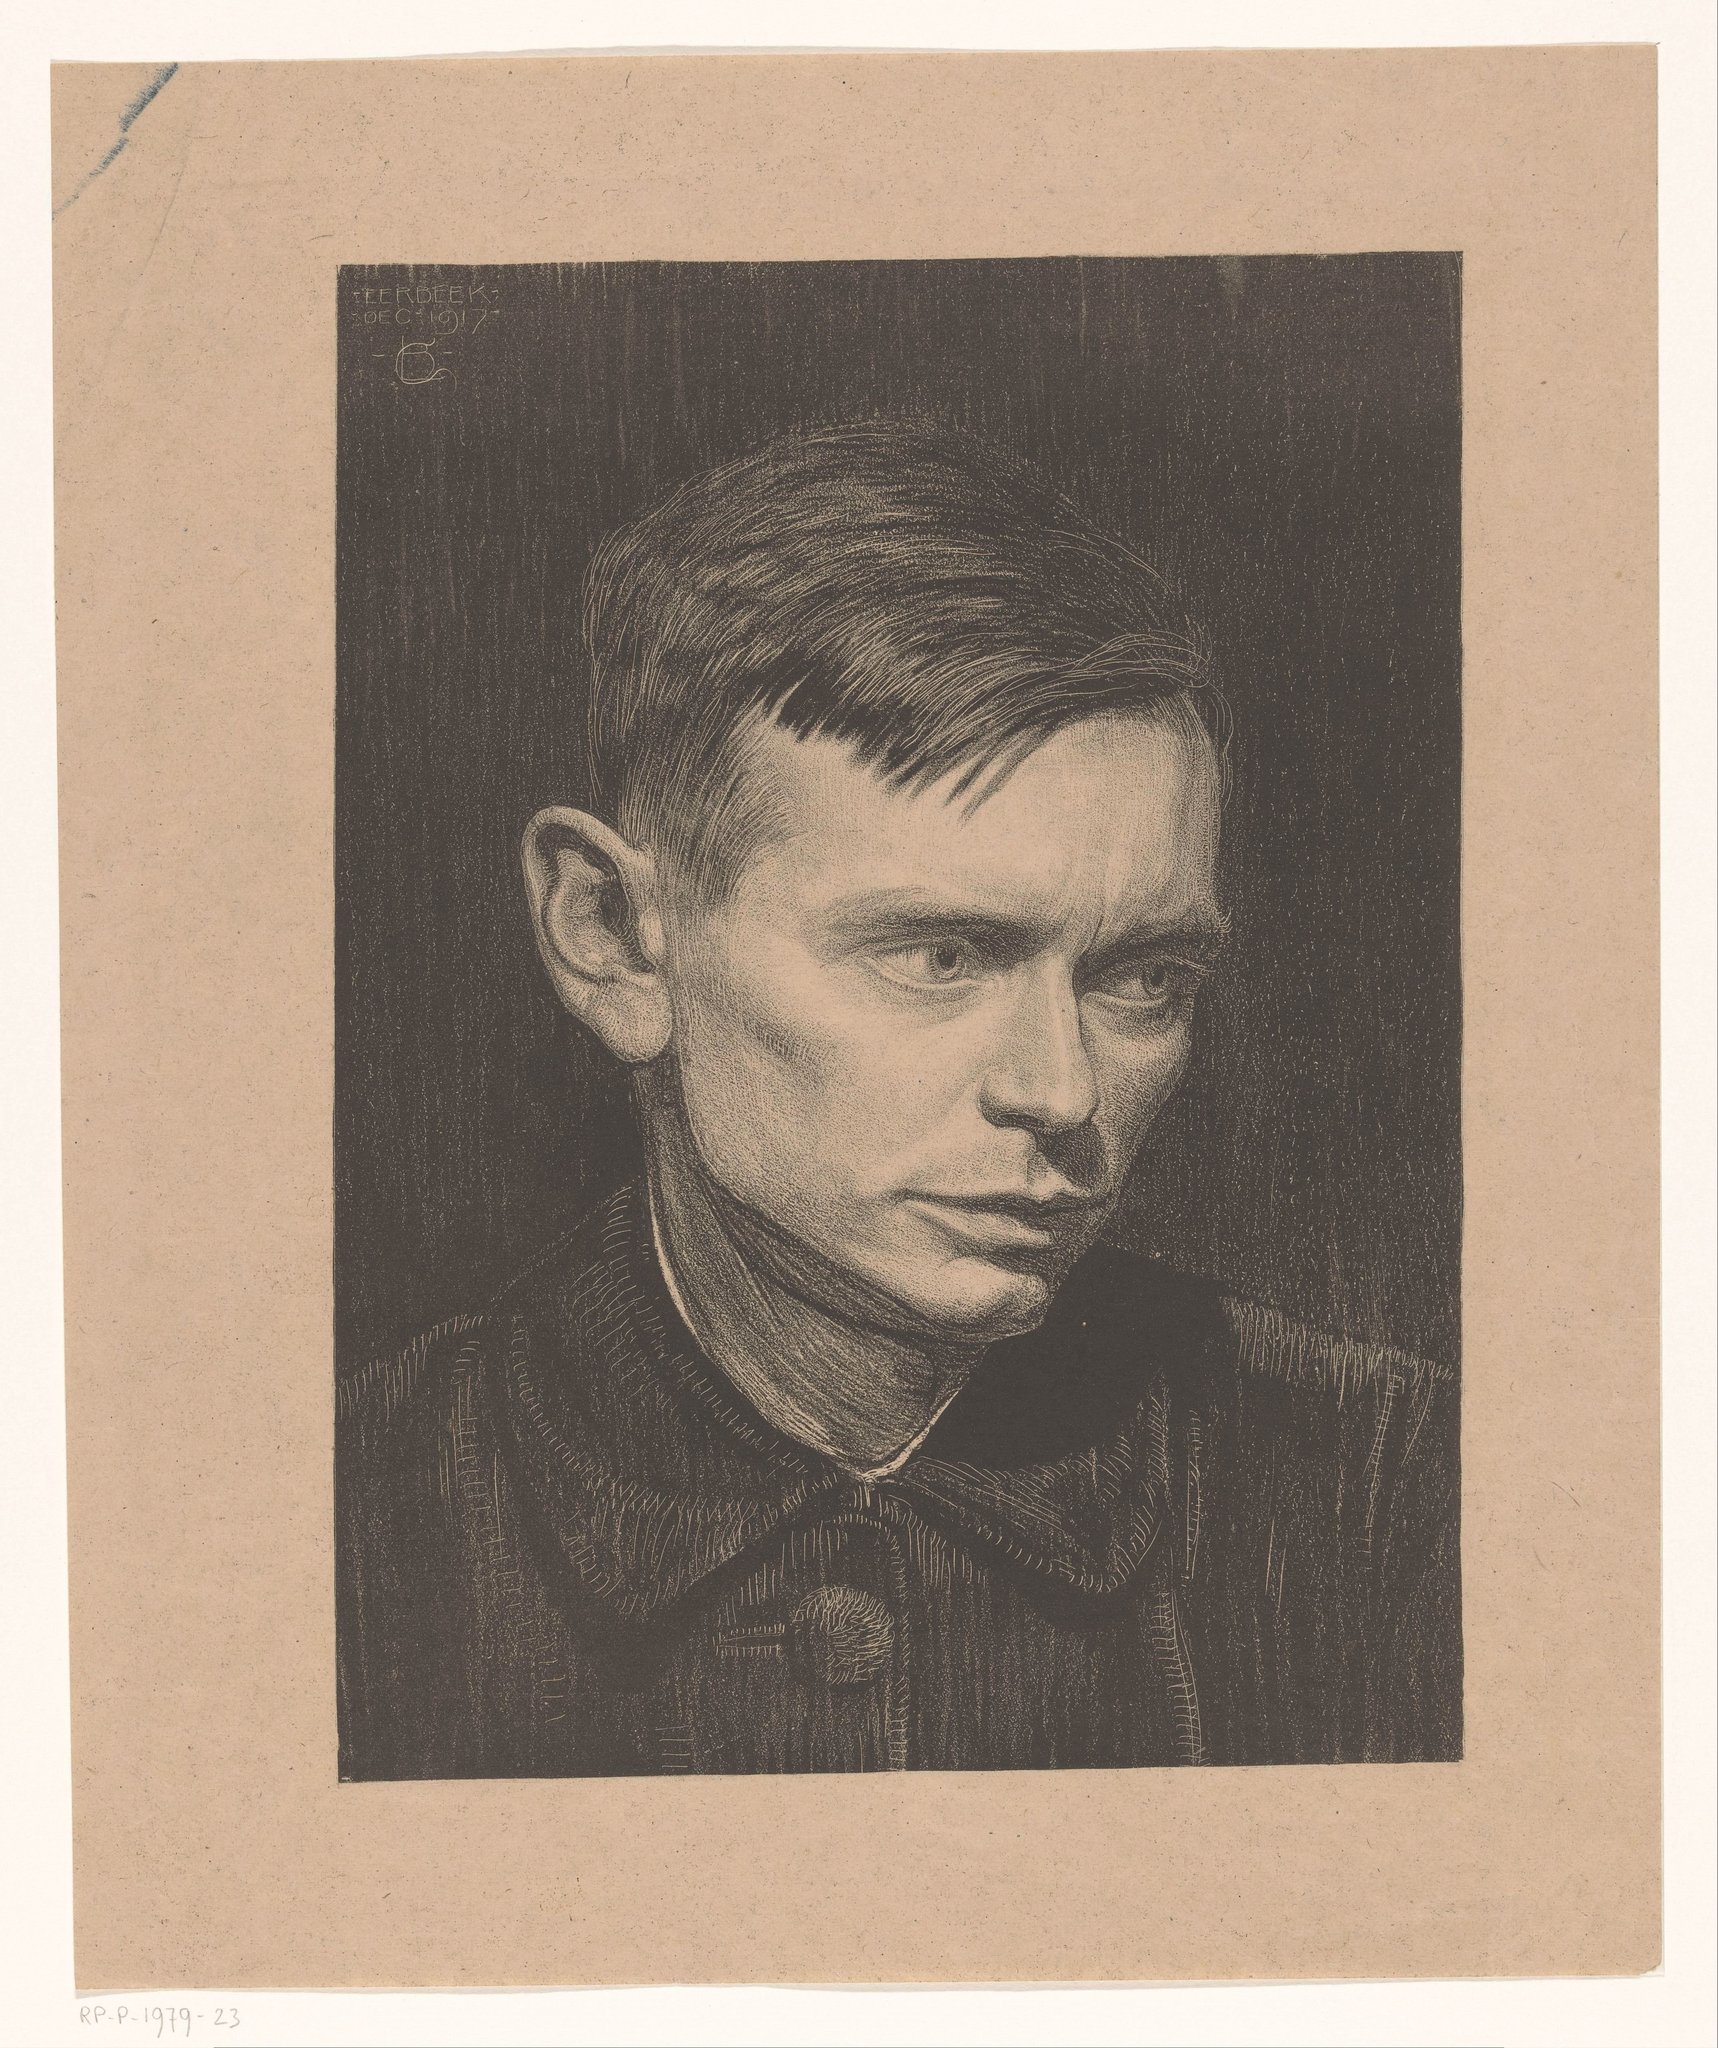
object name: print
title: Portret van Jan Mankes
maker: chris lebeau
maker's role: draughtsman, print maker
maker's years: 1878-1945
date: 1912-1917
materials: paper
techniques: lithograph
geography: eerbeek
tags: painter, jan mankes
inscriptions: collector's mark: Lugt 2228, collector's mark: Lugt 2760